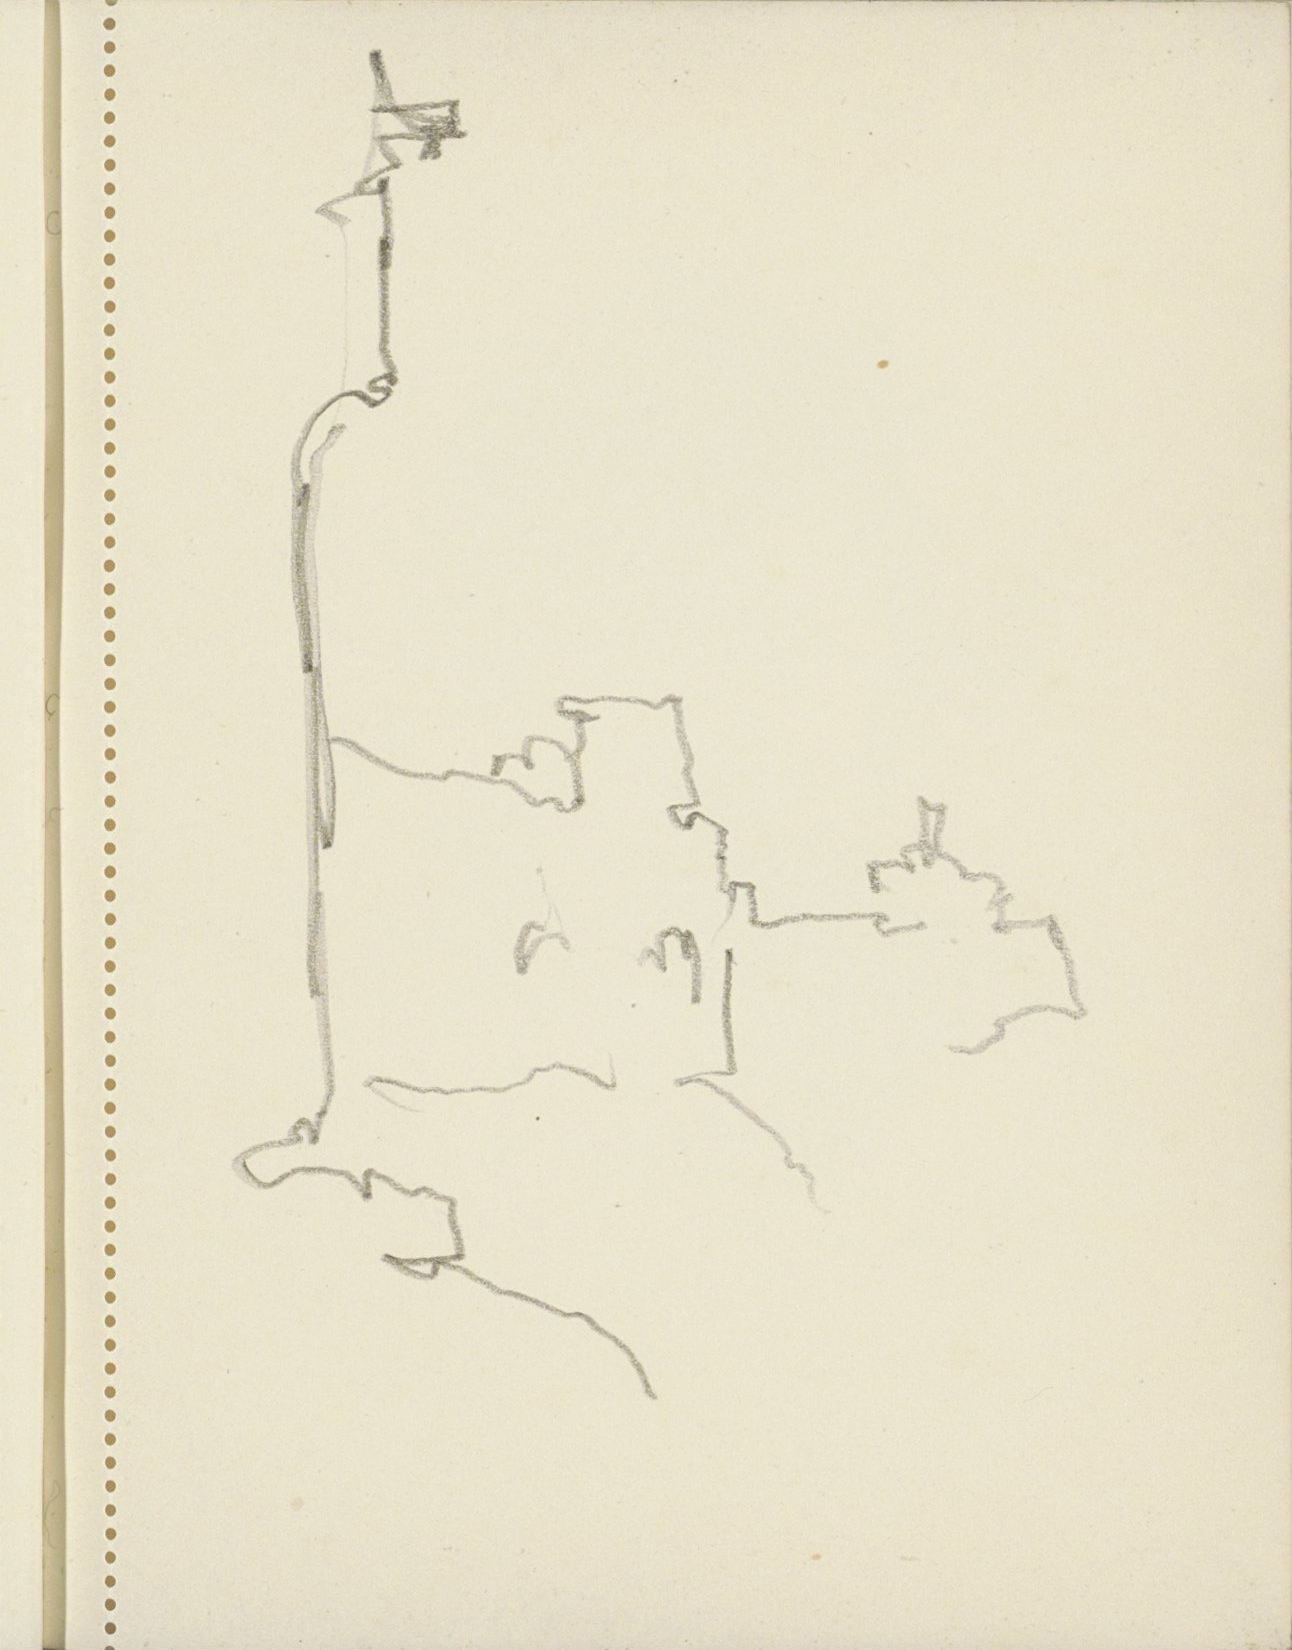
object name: sketchbook leaf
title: Straatgezicht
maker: cornelis vreedenburgh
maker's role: draughtsman, print maker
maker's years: 1880-1946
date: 1890-1946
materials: paper, pencil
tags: street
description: Blad 36 recto uit een schetsboek met 71 bladen.